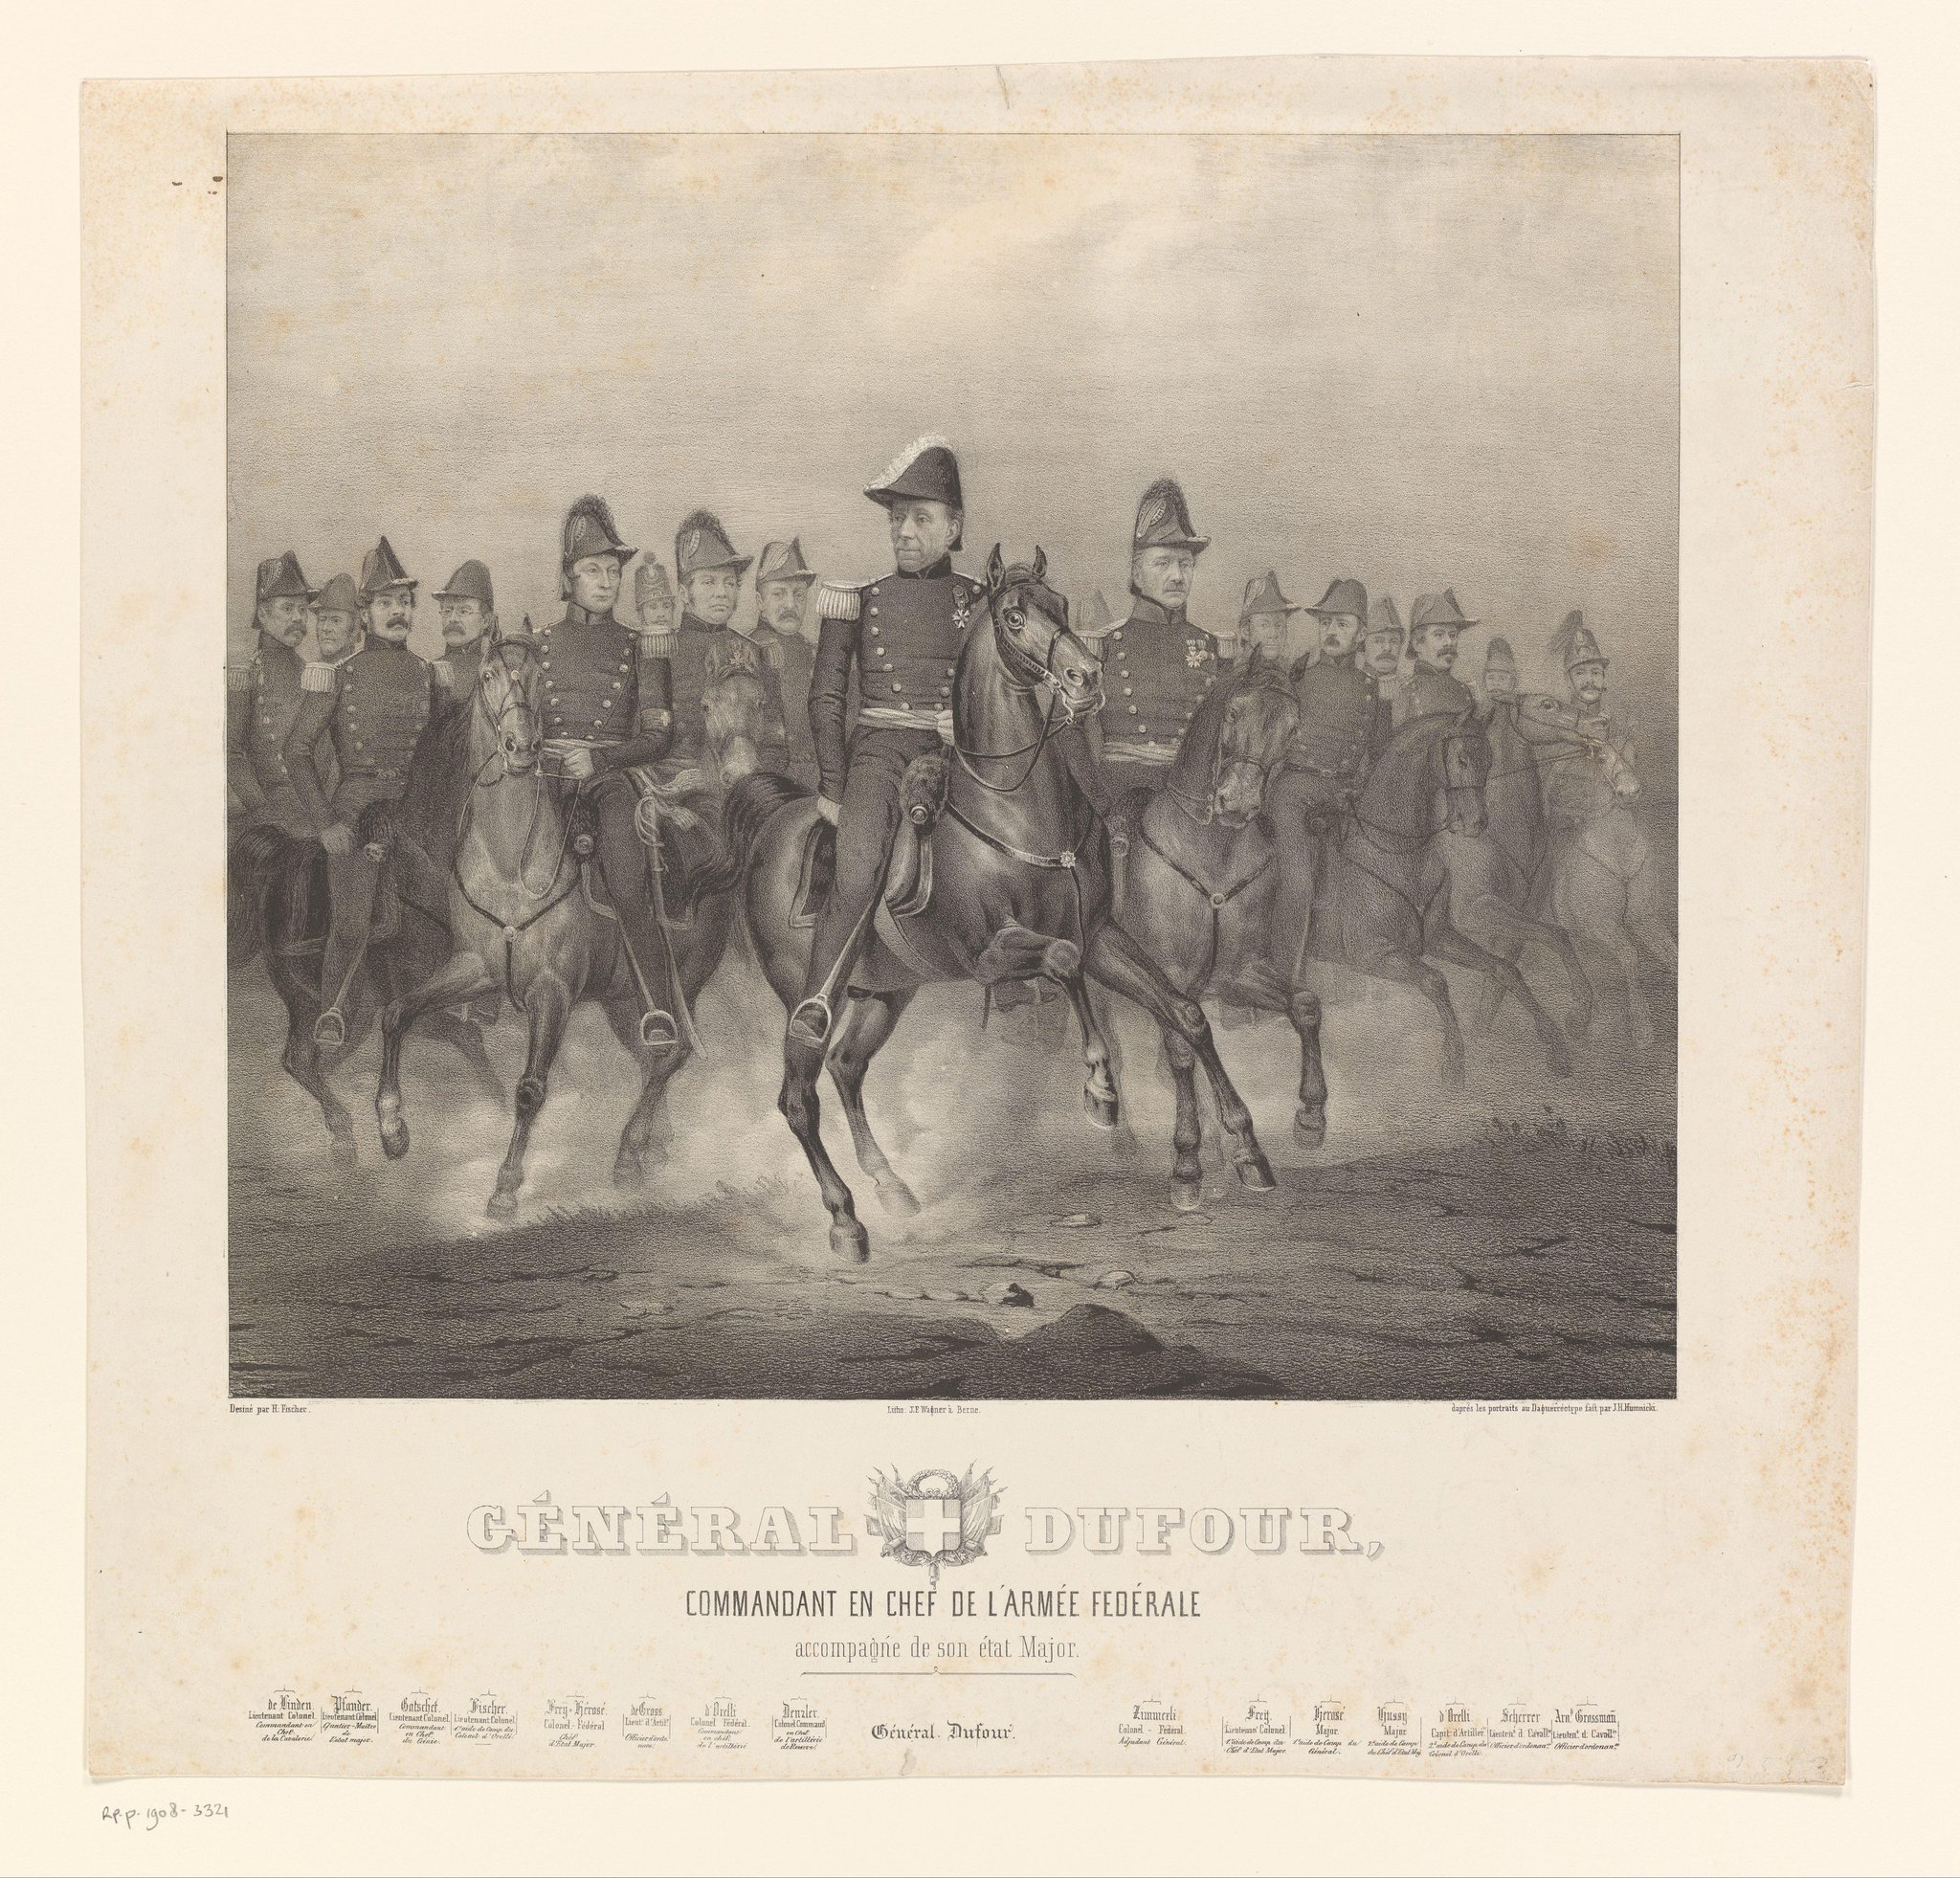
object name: print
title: Général Dufour, commandant en chef de l'armée fedérale accompagné de son état Major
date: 1811-1870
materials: paper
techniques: lithograph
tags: riding a horse, ass, or mule; rider, horseman, commander-in-chief, general, marshal, historical persons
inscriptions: collector's mark: Lugt 2228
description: Portretten van generaal Guillaume Henri Dufour, De Linden, Pfander, Gatschet, Fischer, Friedrich Frey-Herosé, de Gross, d'Orelli, Louis Denzler, Zimmerli, Frey, Herosé, Hussy, d'Orelli, Scherrer en Arnd. Grossman.